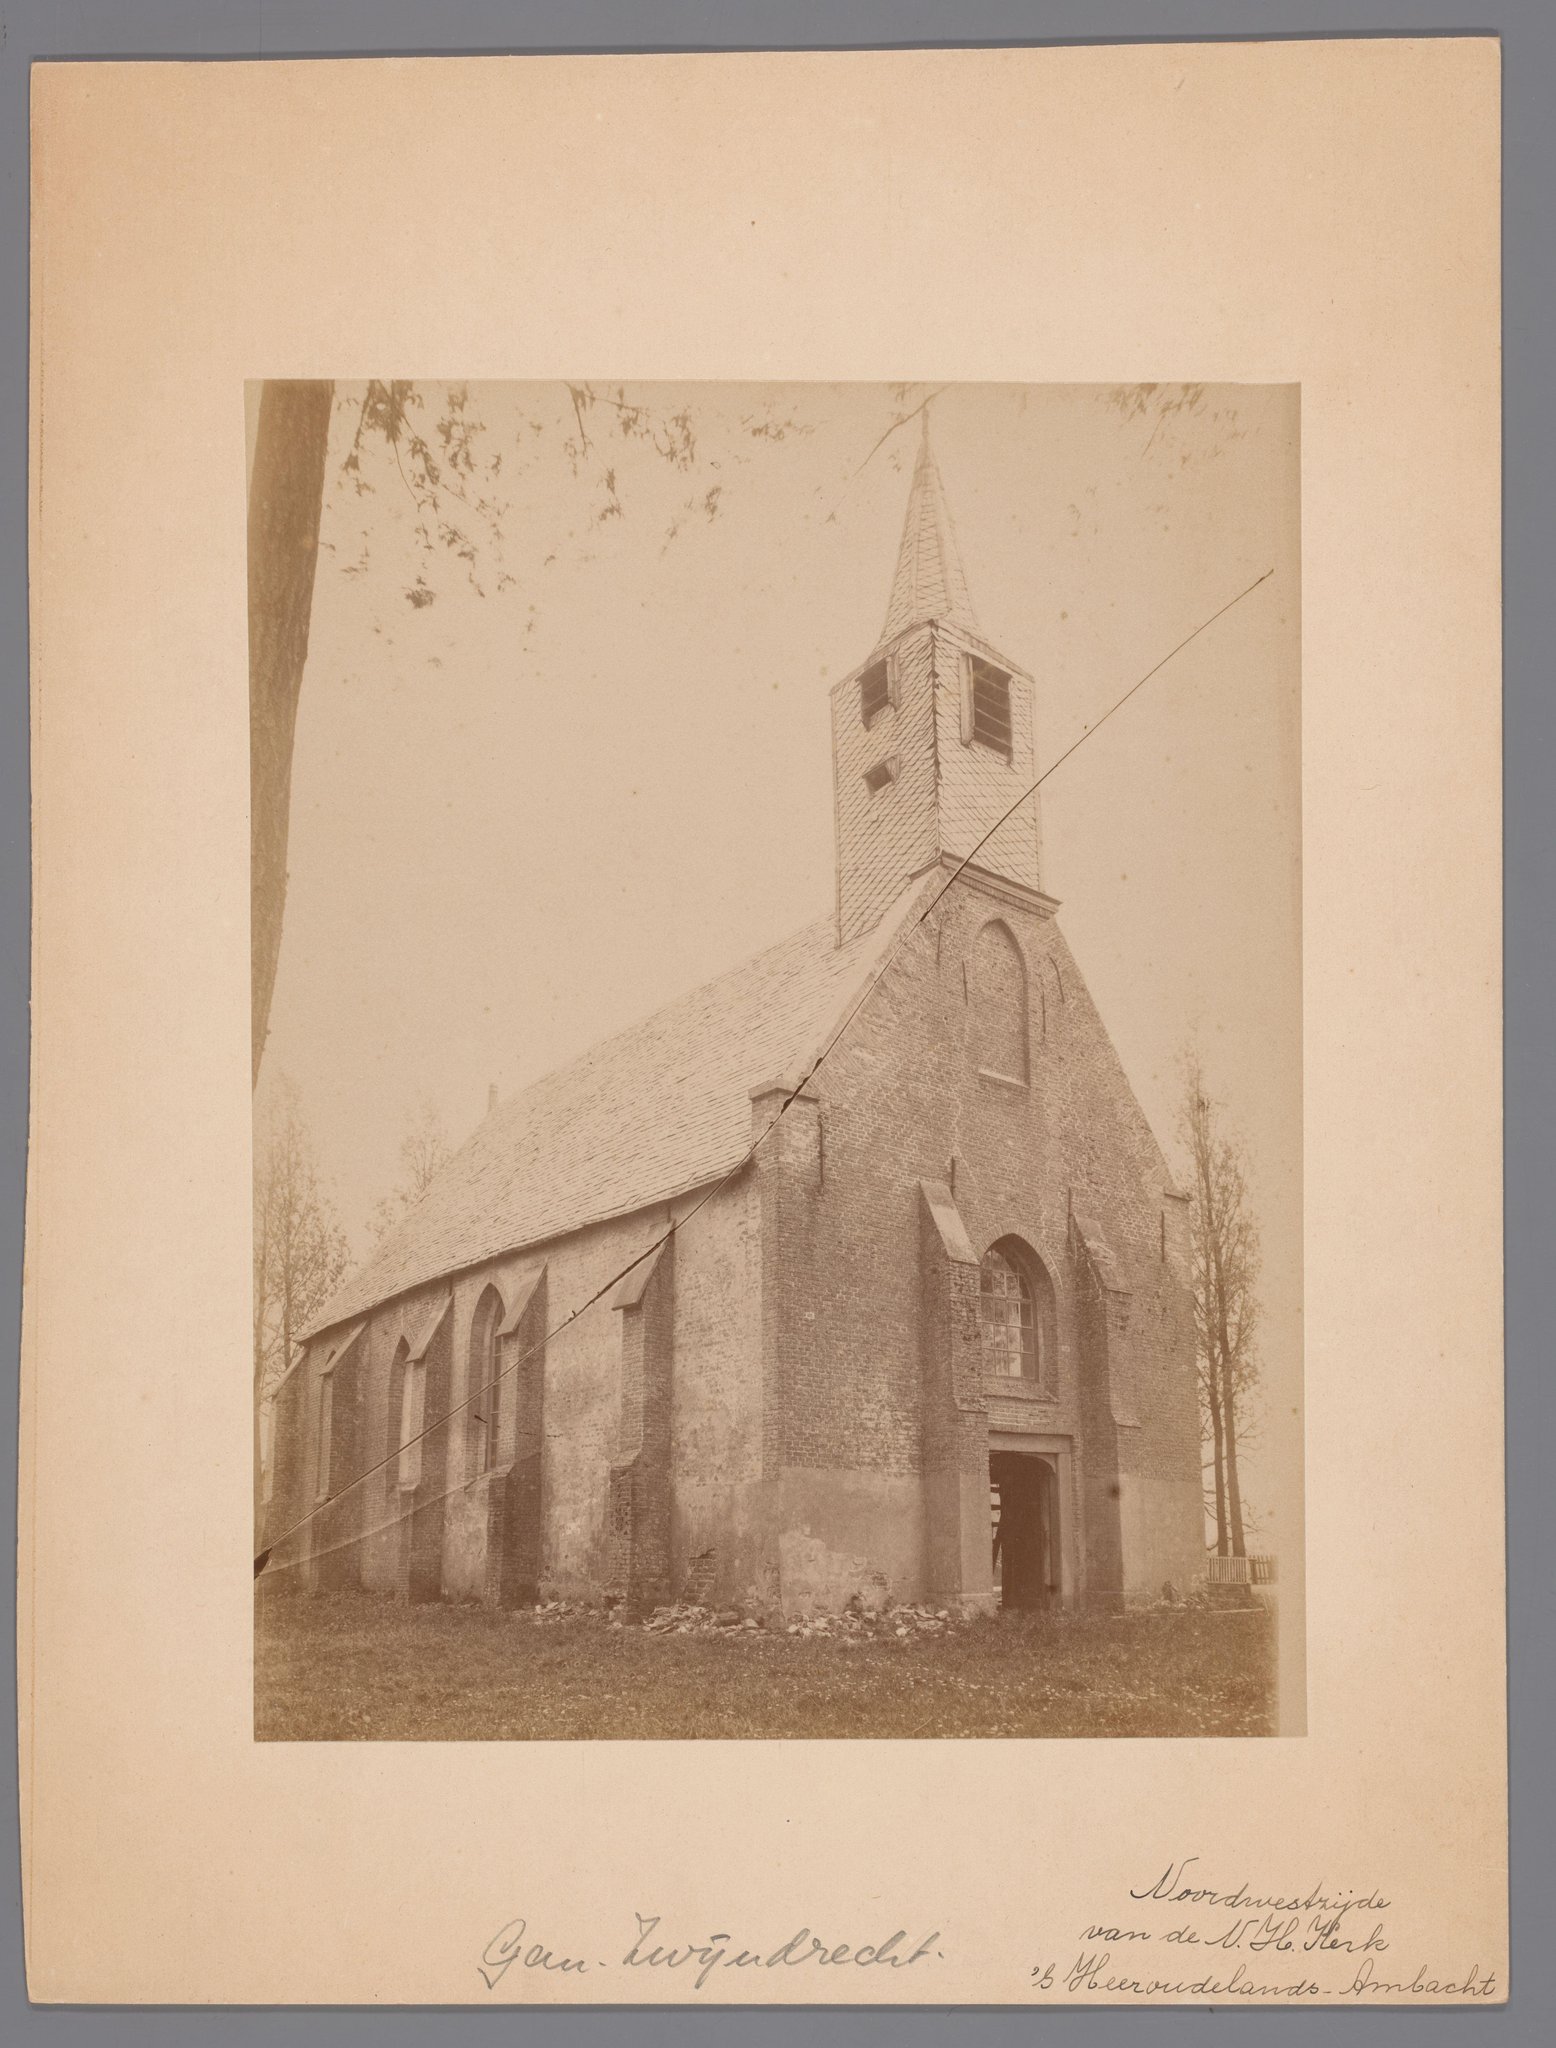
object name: photograph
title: Gezicht op de Onderwegkerk of Pietermankerk te Zwijndrecht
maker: anoniem (monumentenzorg)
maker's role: fotograaf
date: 1892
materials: cardboard, photographic support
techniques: albumen print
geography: zwijndrecht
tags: church (exterior)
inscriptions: annotation: ‘'s Heer oudelands ambacht/ Noordwestzijde van de N.H. Kerk/ Juni 1892’, annotation: ‘Gem. Zwijndrecht/ Noordwestzijde van de N.H. Kerk/ 's Heer oudelands-Ambacht’